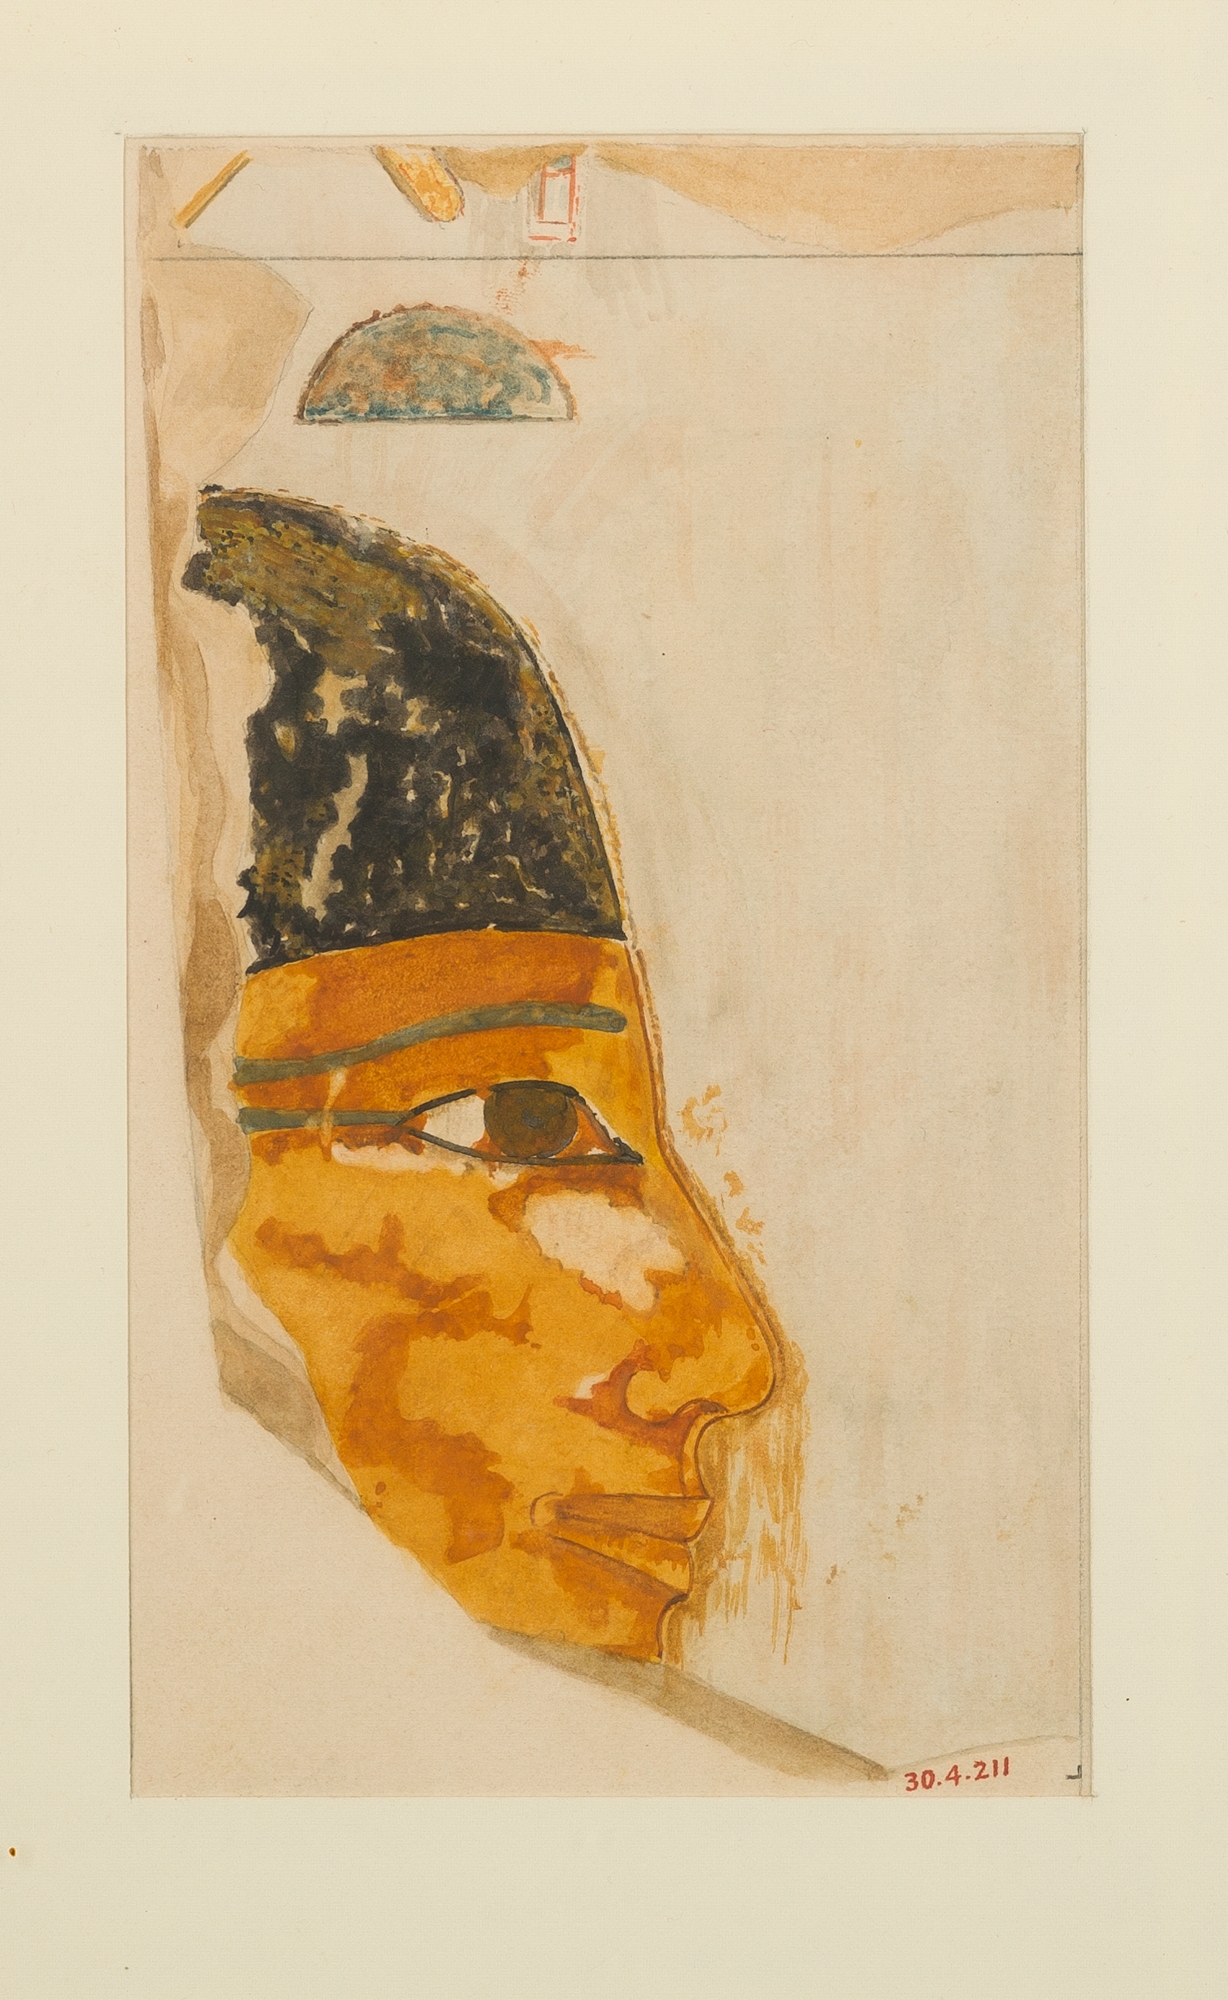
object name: facsimile, puyemre tt 39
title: Face of Seniseneb, Tomb of Puyemre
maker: norman de garis davies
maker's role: artist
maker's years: 1865-1941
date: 1479-1458 BCE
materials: paper, paint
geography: egypt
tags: faces,women